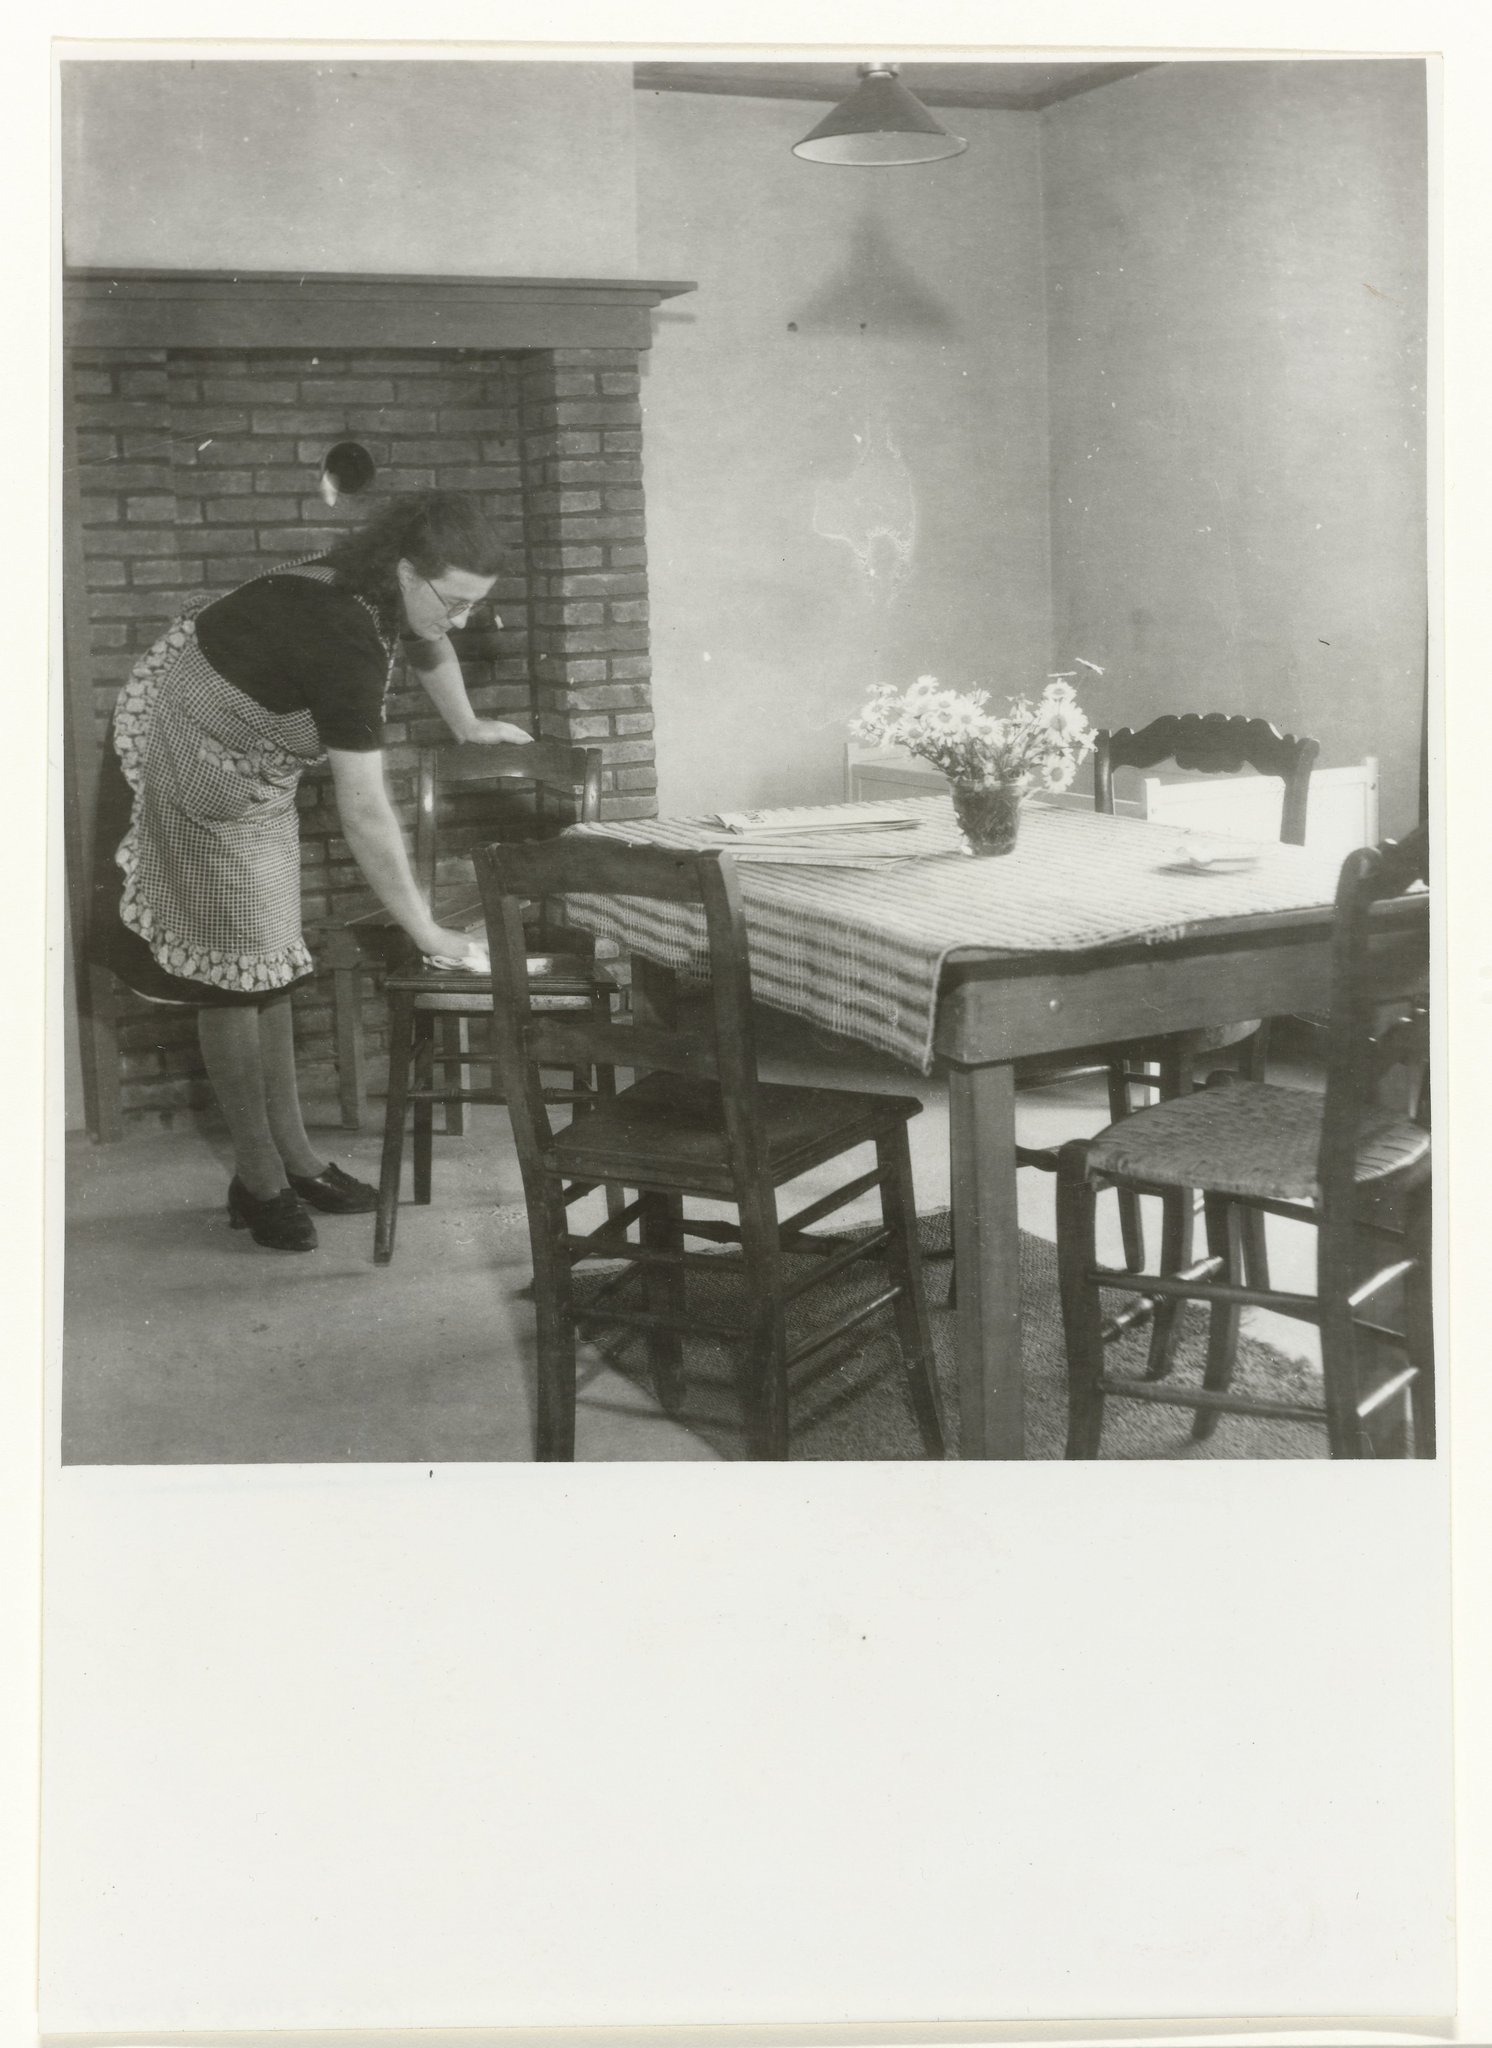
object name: documentary photograph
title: Stoffende vrouw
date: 1945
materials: photographic support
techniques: photography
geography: netherlands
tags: netherlands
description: In een eenvoudig gemeubileerde huiskamer is een vrouw bezig een stoel af te stoffen. Zij draagt een bril en een geruit schort. In de huiskamer staat een tafel met een geruit tafelkleed en een vaas met bloemen, aan het plafond een lamp. Achter in de kamer een kinderledikant.